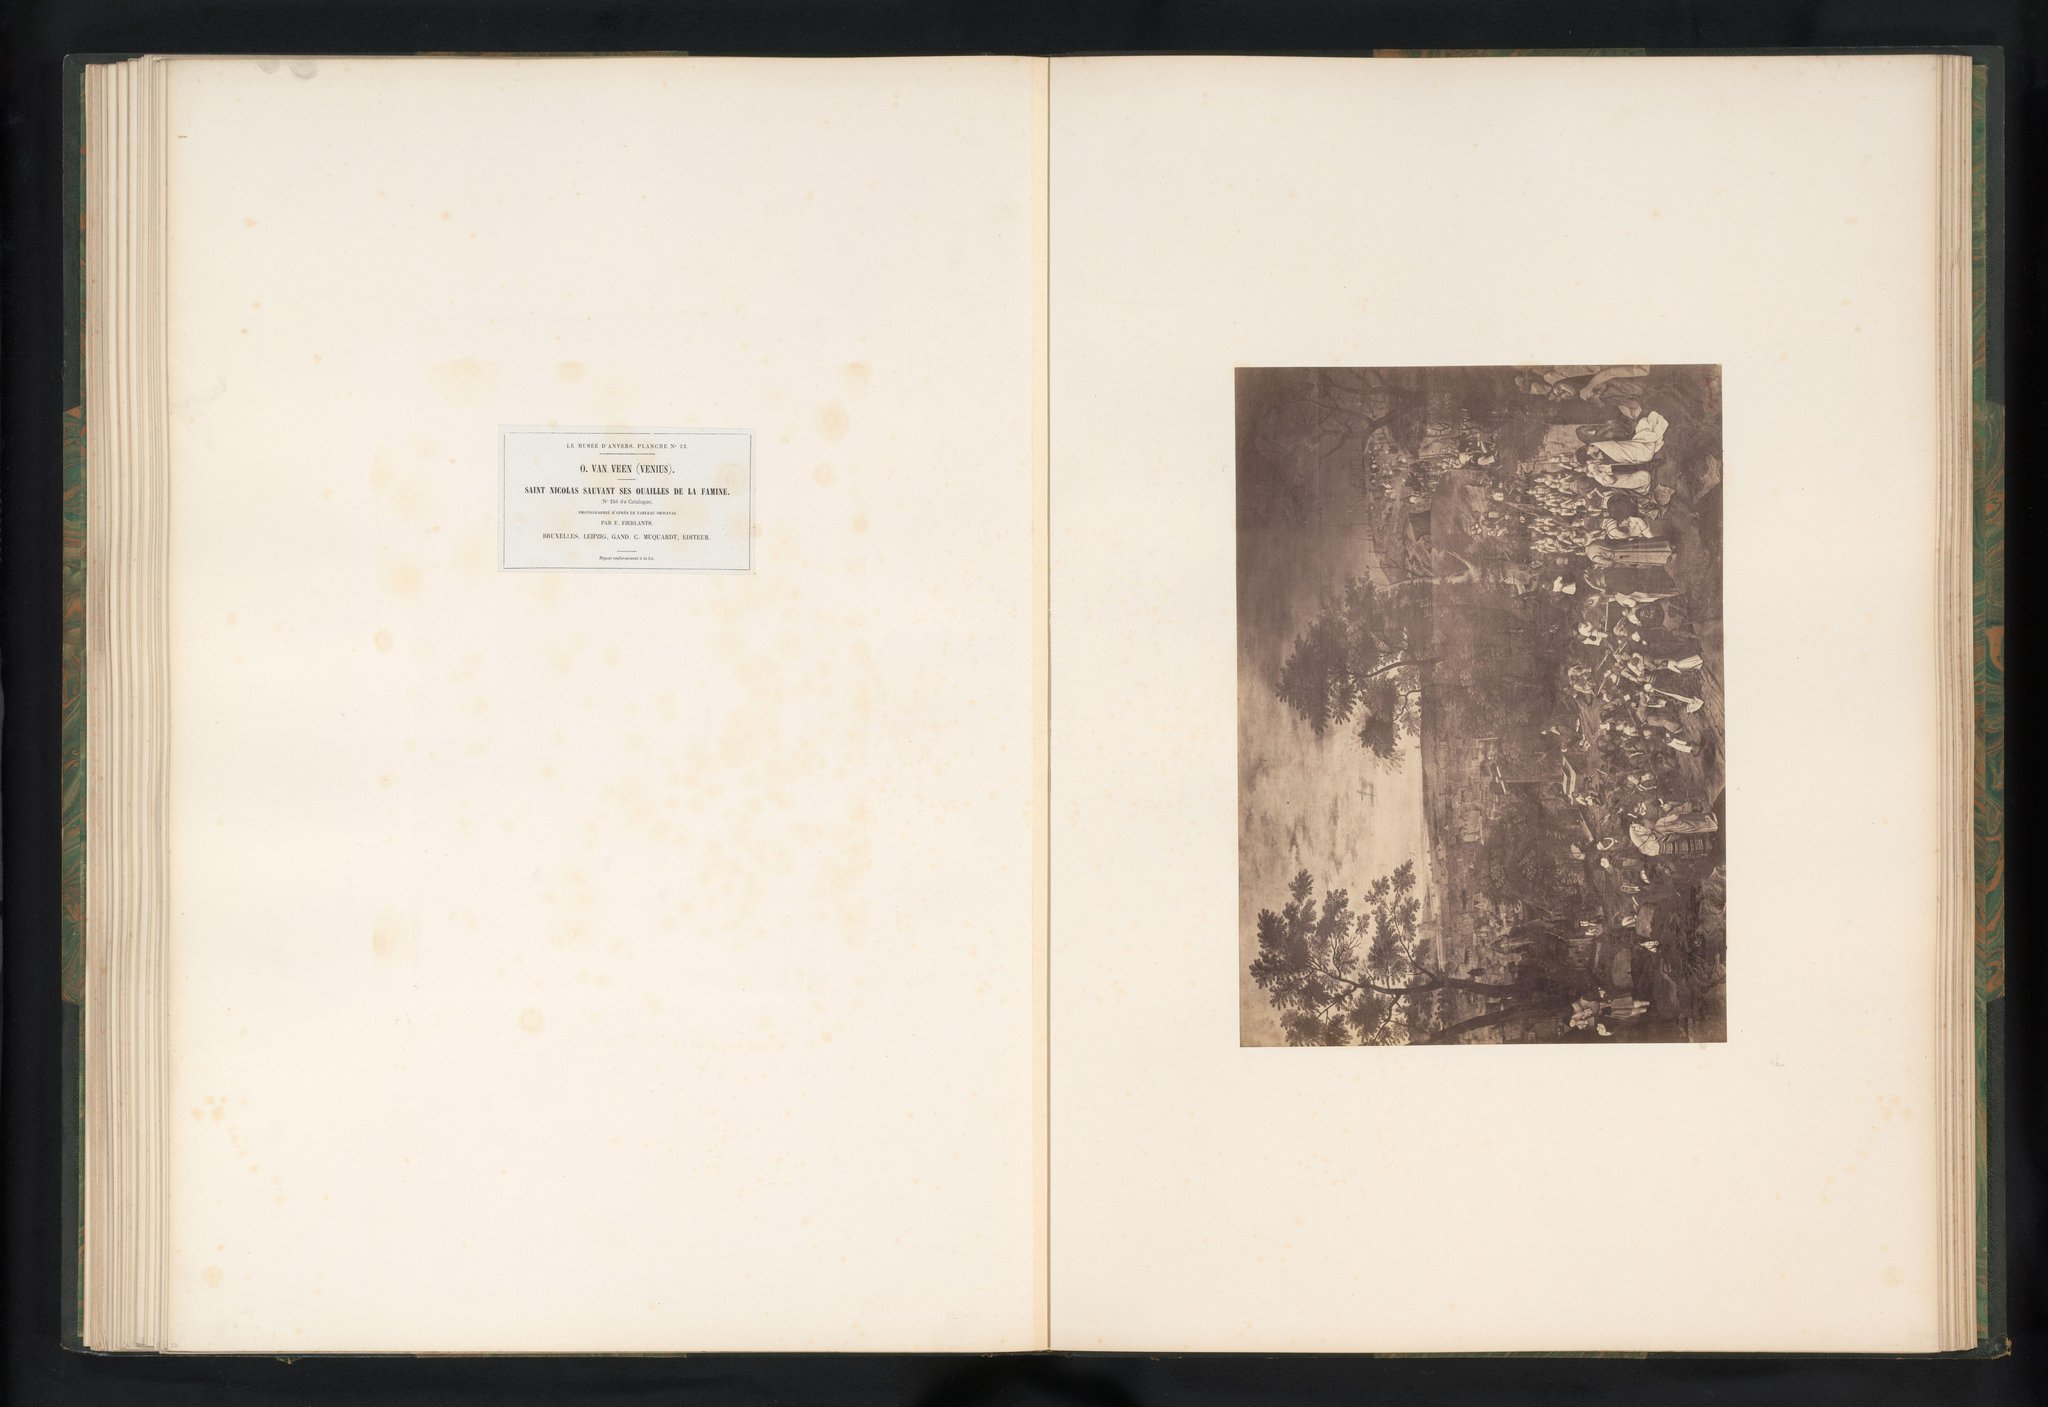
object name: photograph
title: Fotoreproductie van de Kruisdraging door Pieter Brueghel II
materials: photographic support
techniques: albumen print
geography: brussels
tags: carrying of the cross: christ bearing the cross, alone or with the help of others (e.g. simon the cyrenian)